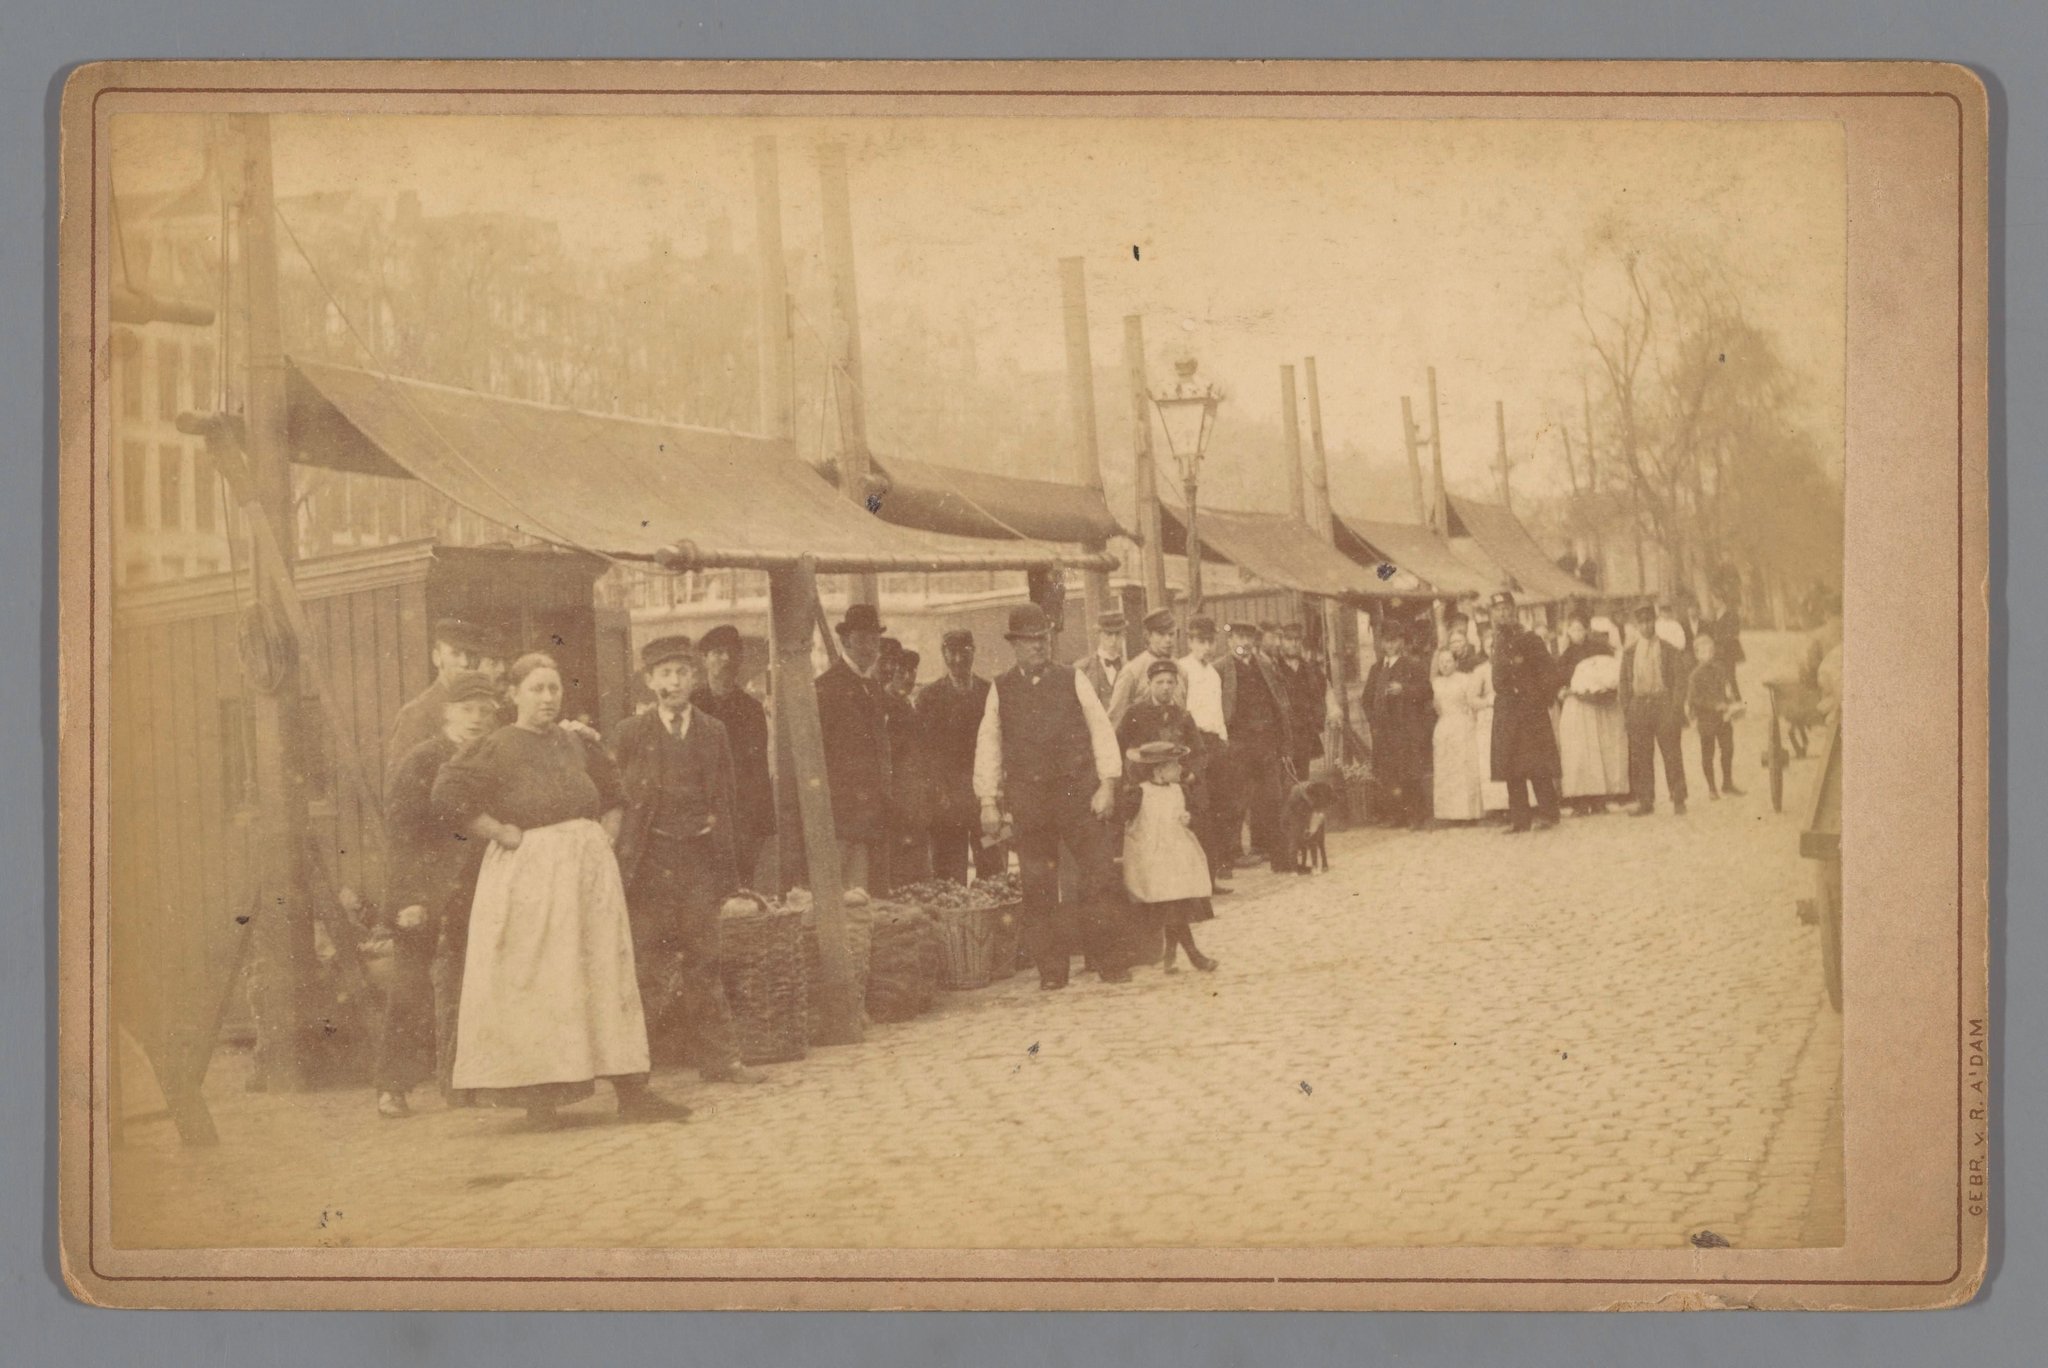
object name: cabinet photograph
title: Gezicht op de Appelmarkt in Amsterdam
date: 1850-1900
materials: cardboard, photographic support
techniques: albumen print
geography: amsterdam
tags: adult woman (+ more than eight persons), adult man (+ more than eight persons), street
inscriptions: annotation: ‘Appelmarkt Singel’, annotation: ‘[...] Raam- en Heisteeg/ van 1616 [..] 1895/ markt[...] steeg tot 1940/ 1895 markt an [...]/ 1934 naar [...]’